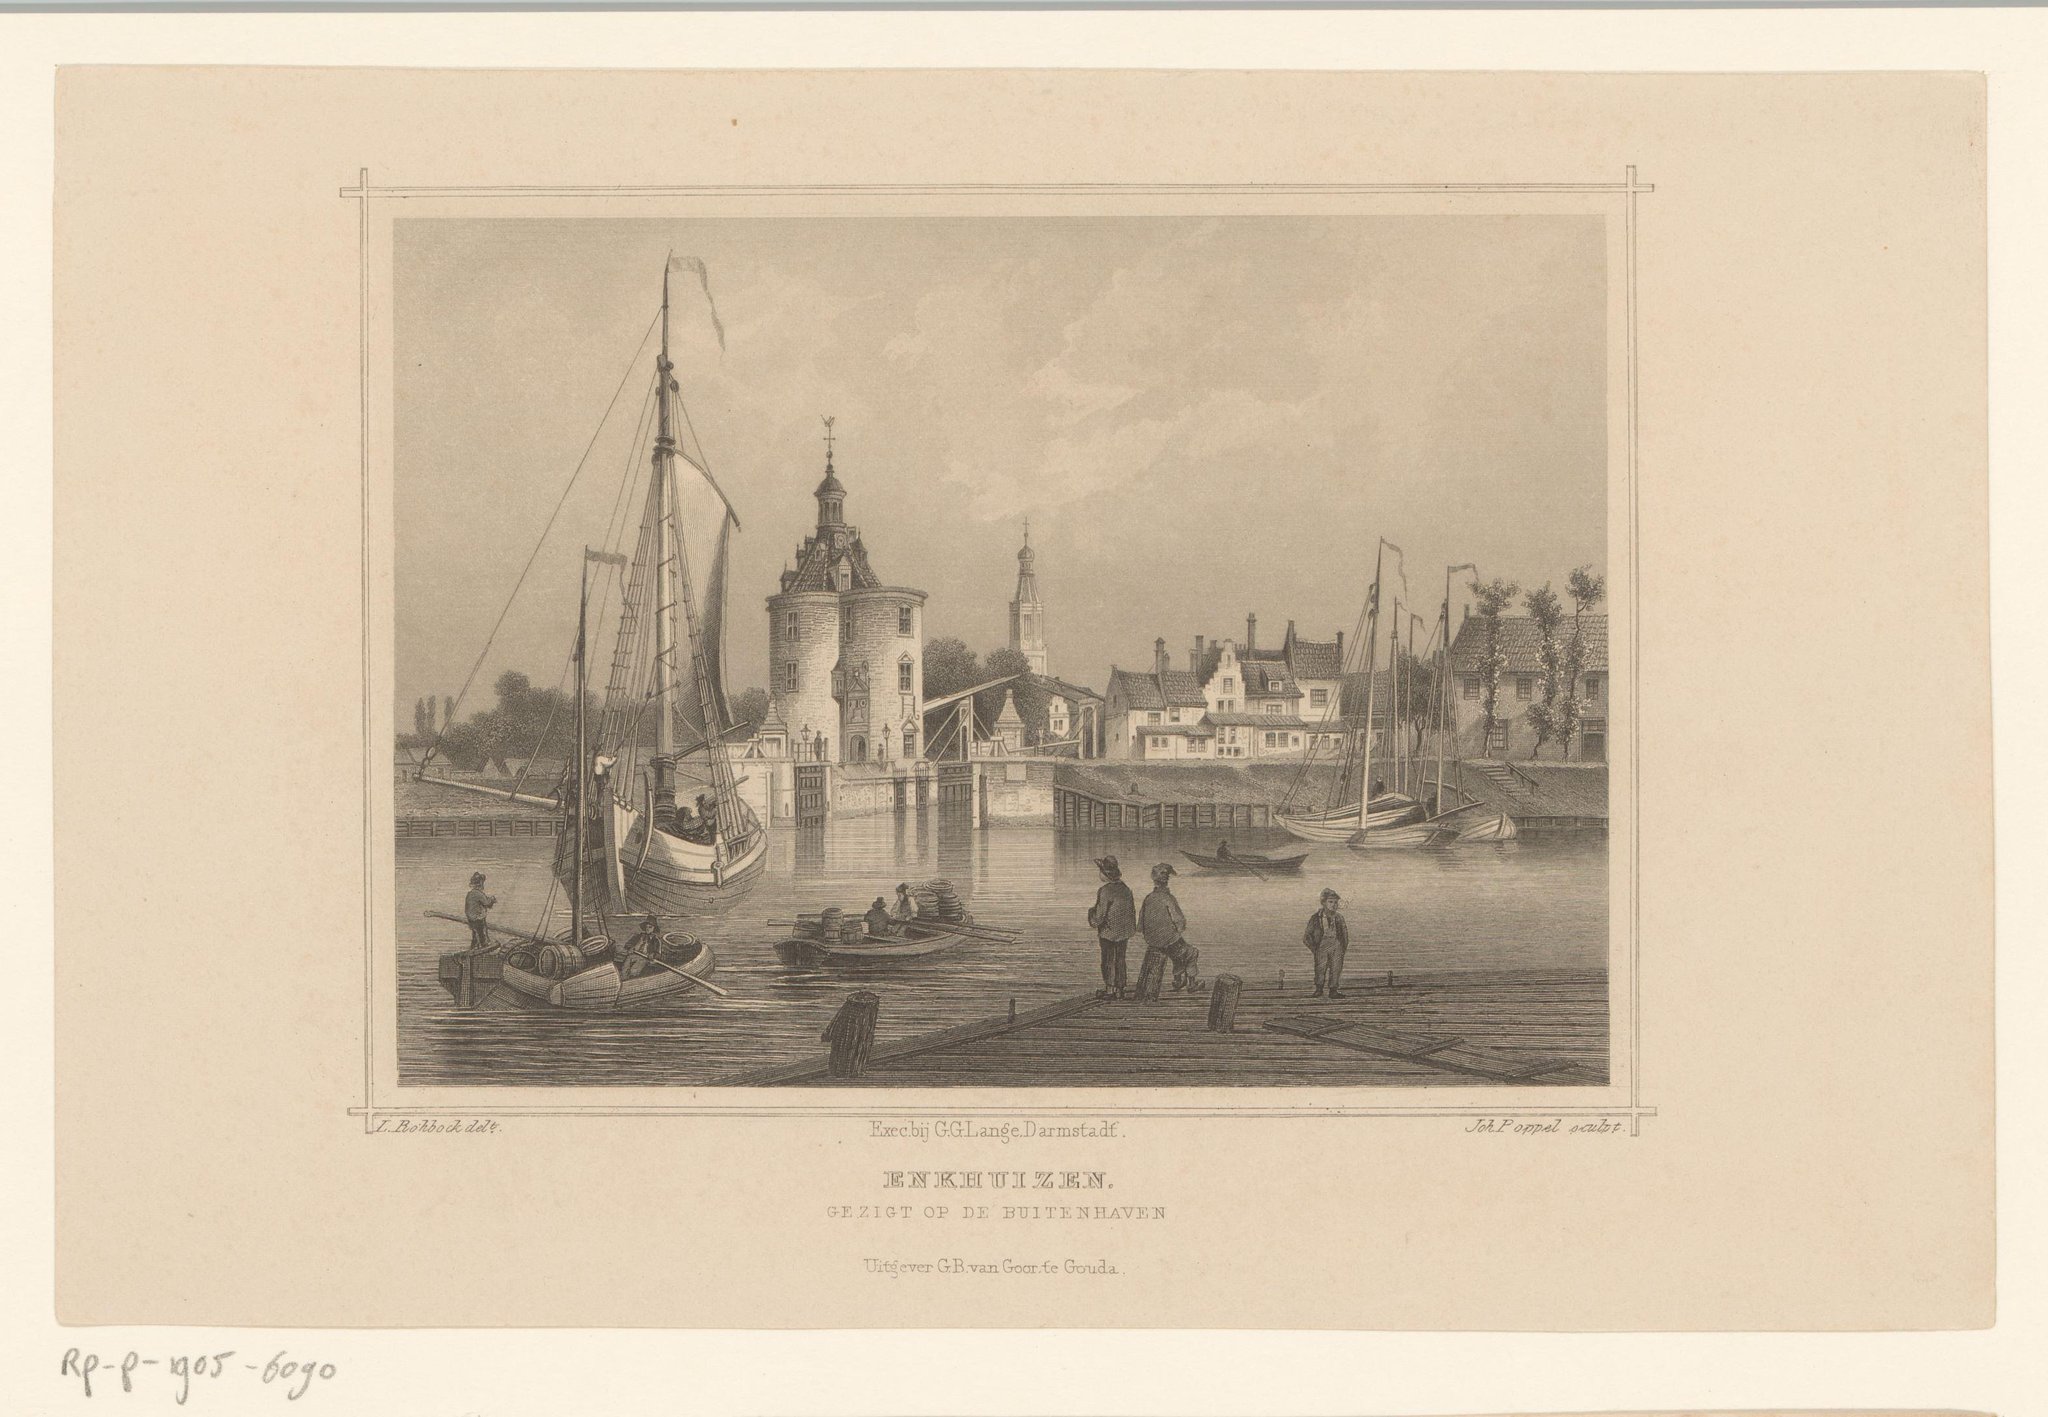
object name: print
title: Enkhuizen. Gezigt op de buitenhaven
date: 1858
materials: paper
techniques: engraving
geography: gouda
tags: harbour, city-view, and landscape with man-made constructions, ships (in general) - cc - more than one ship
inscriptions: collector's mark: Lugt 2228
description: Prent ook gebruikt in: Terwen, Johannes Leonardus. Het Koningrijk der Nederlanden voorgesteld in eene reeks van naar de natuur geteekende schilderachtige gezigten. Gouda: Van Goor, 1858-1862.